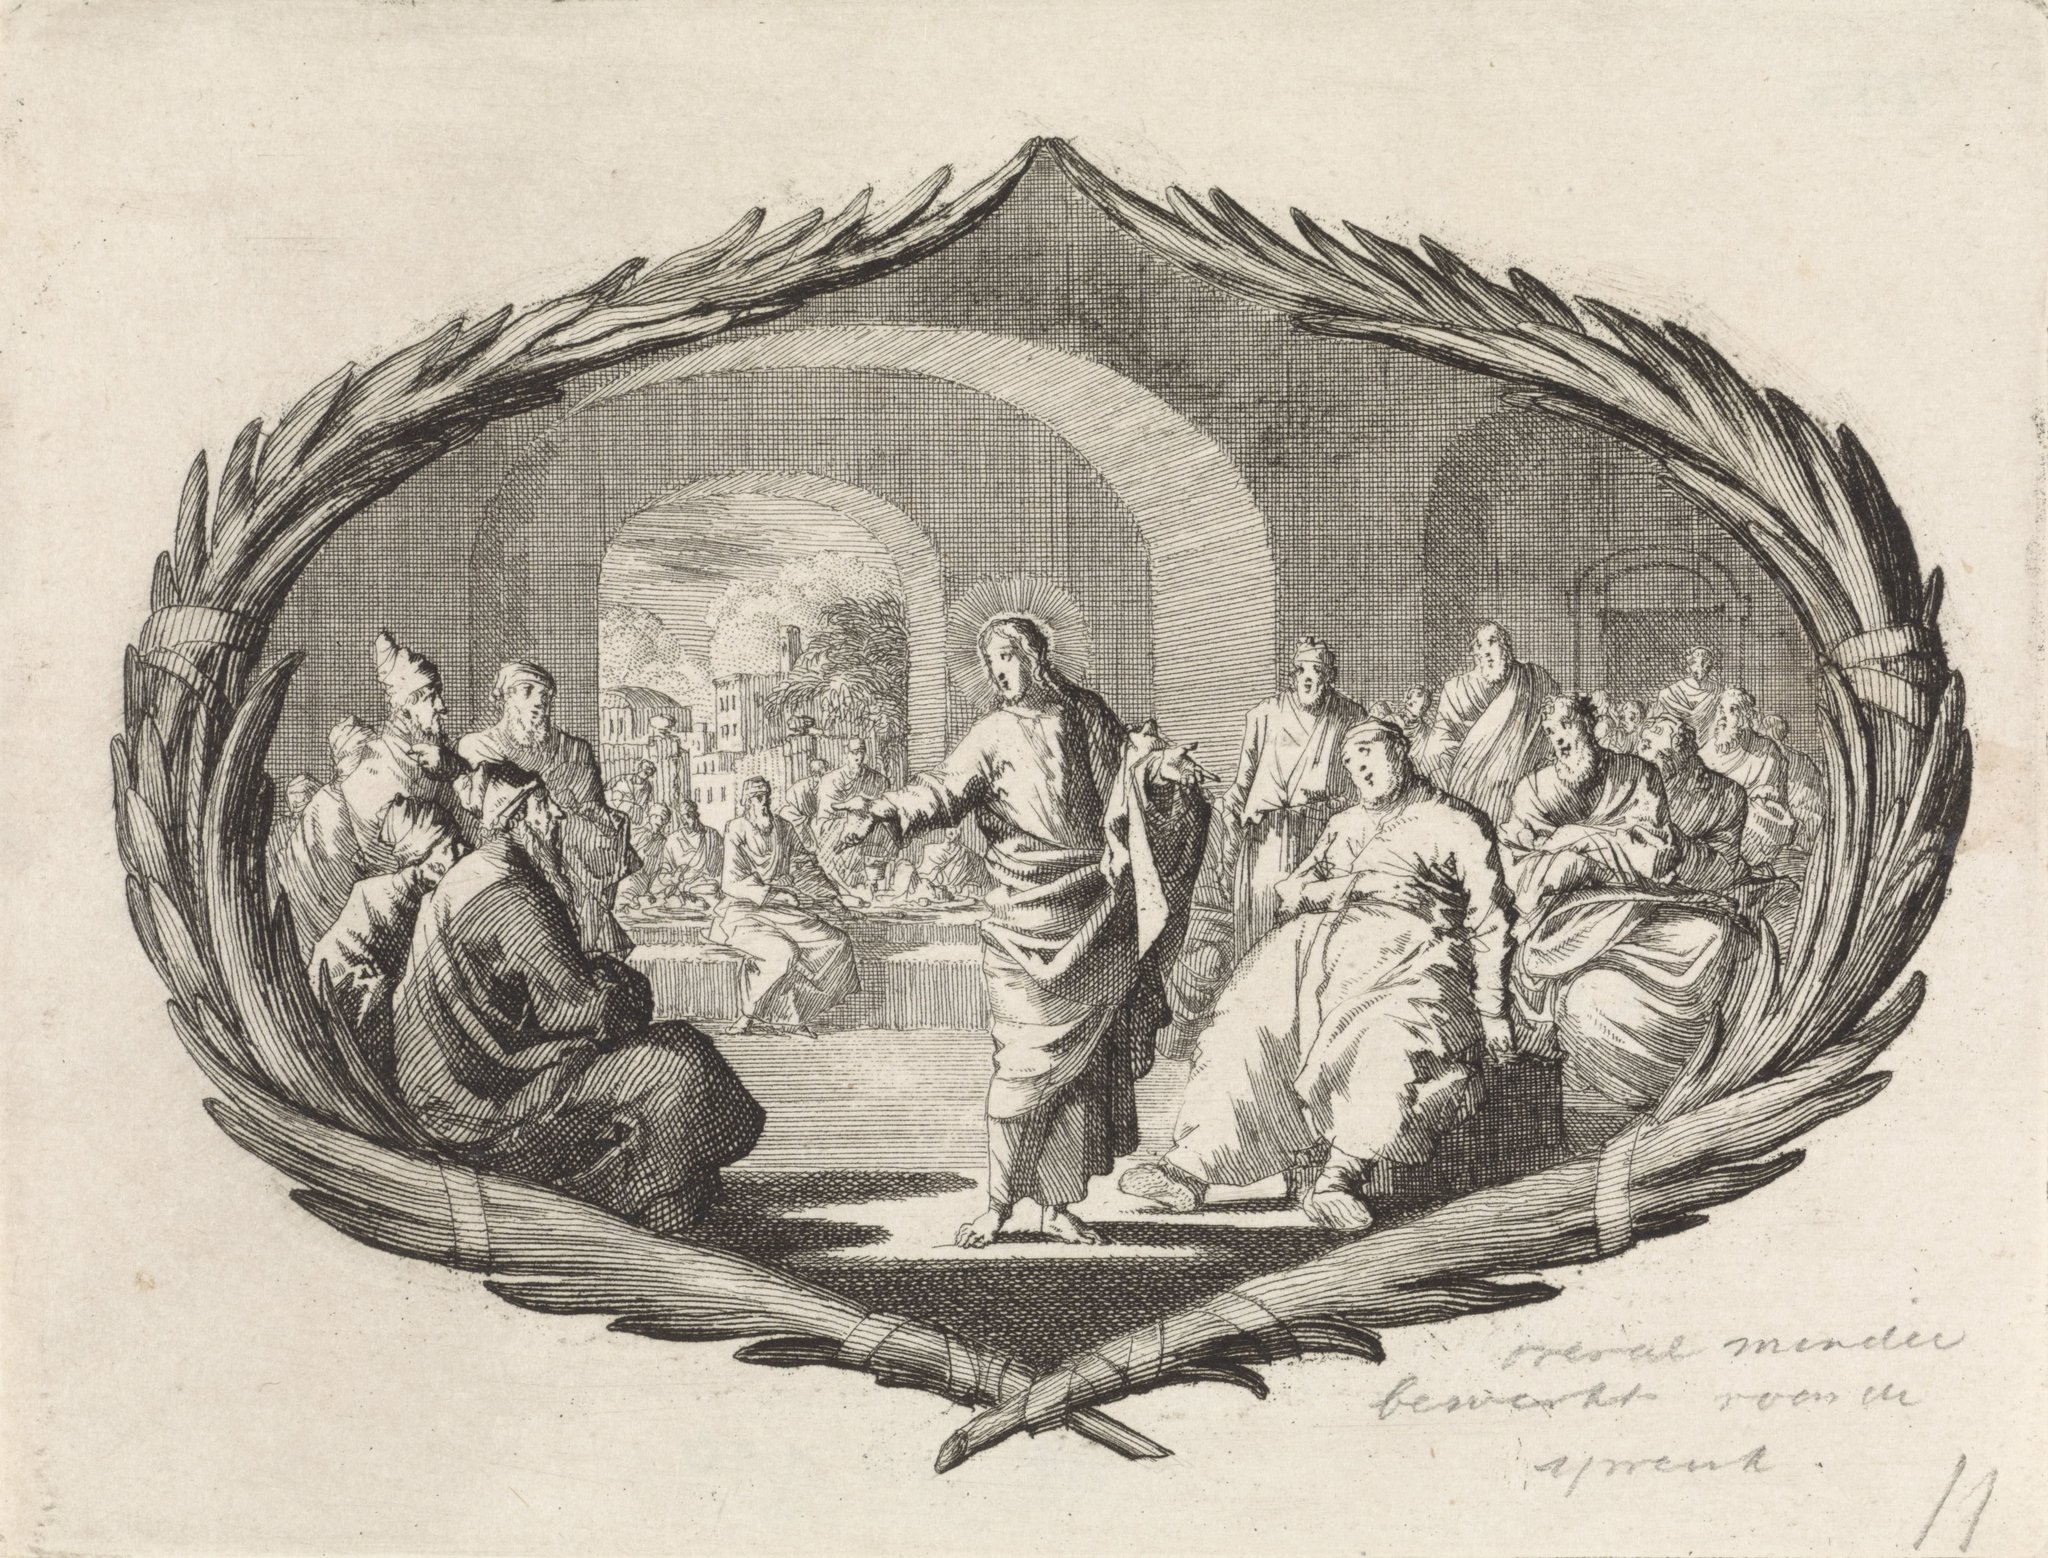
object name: print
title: Genezing van een waterzuchtige man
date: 1700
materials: paper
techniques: etching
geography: amsterdam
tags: healing of a man with dropsy (luke 14:2-4), ornament ~ cartouche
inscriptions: collector's mark: Lugt 2228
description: Een voorstelling in een cartouche van palmtakken. Christus is voor het eten uitgenodigd in het huis van een farizeeër. Hij geneest een man die lijdt aan waterzucht. De zieke man zit naast Christus in een stoel. Op de achtergrond zitten mensen aan tafel.